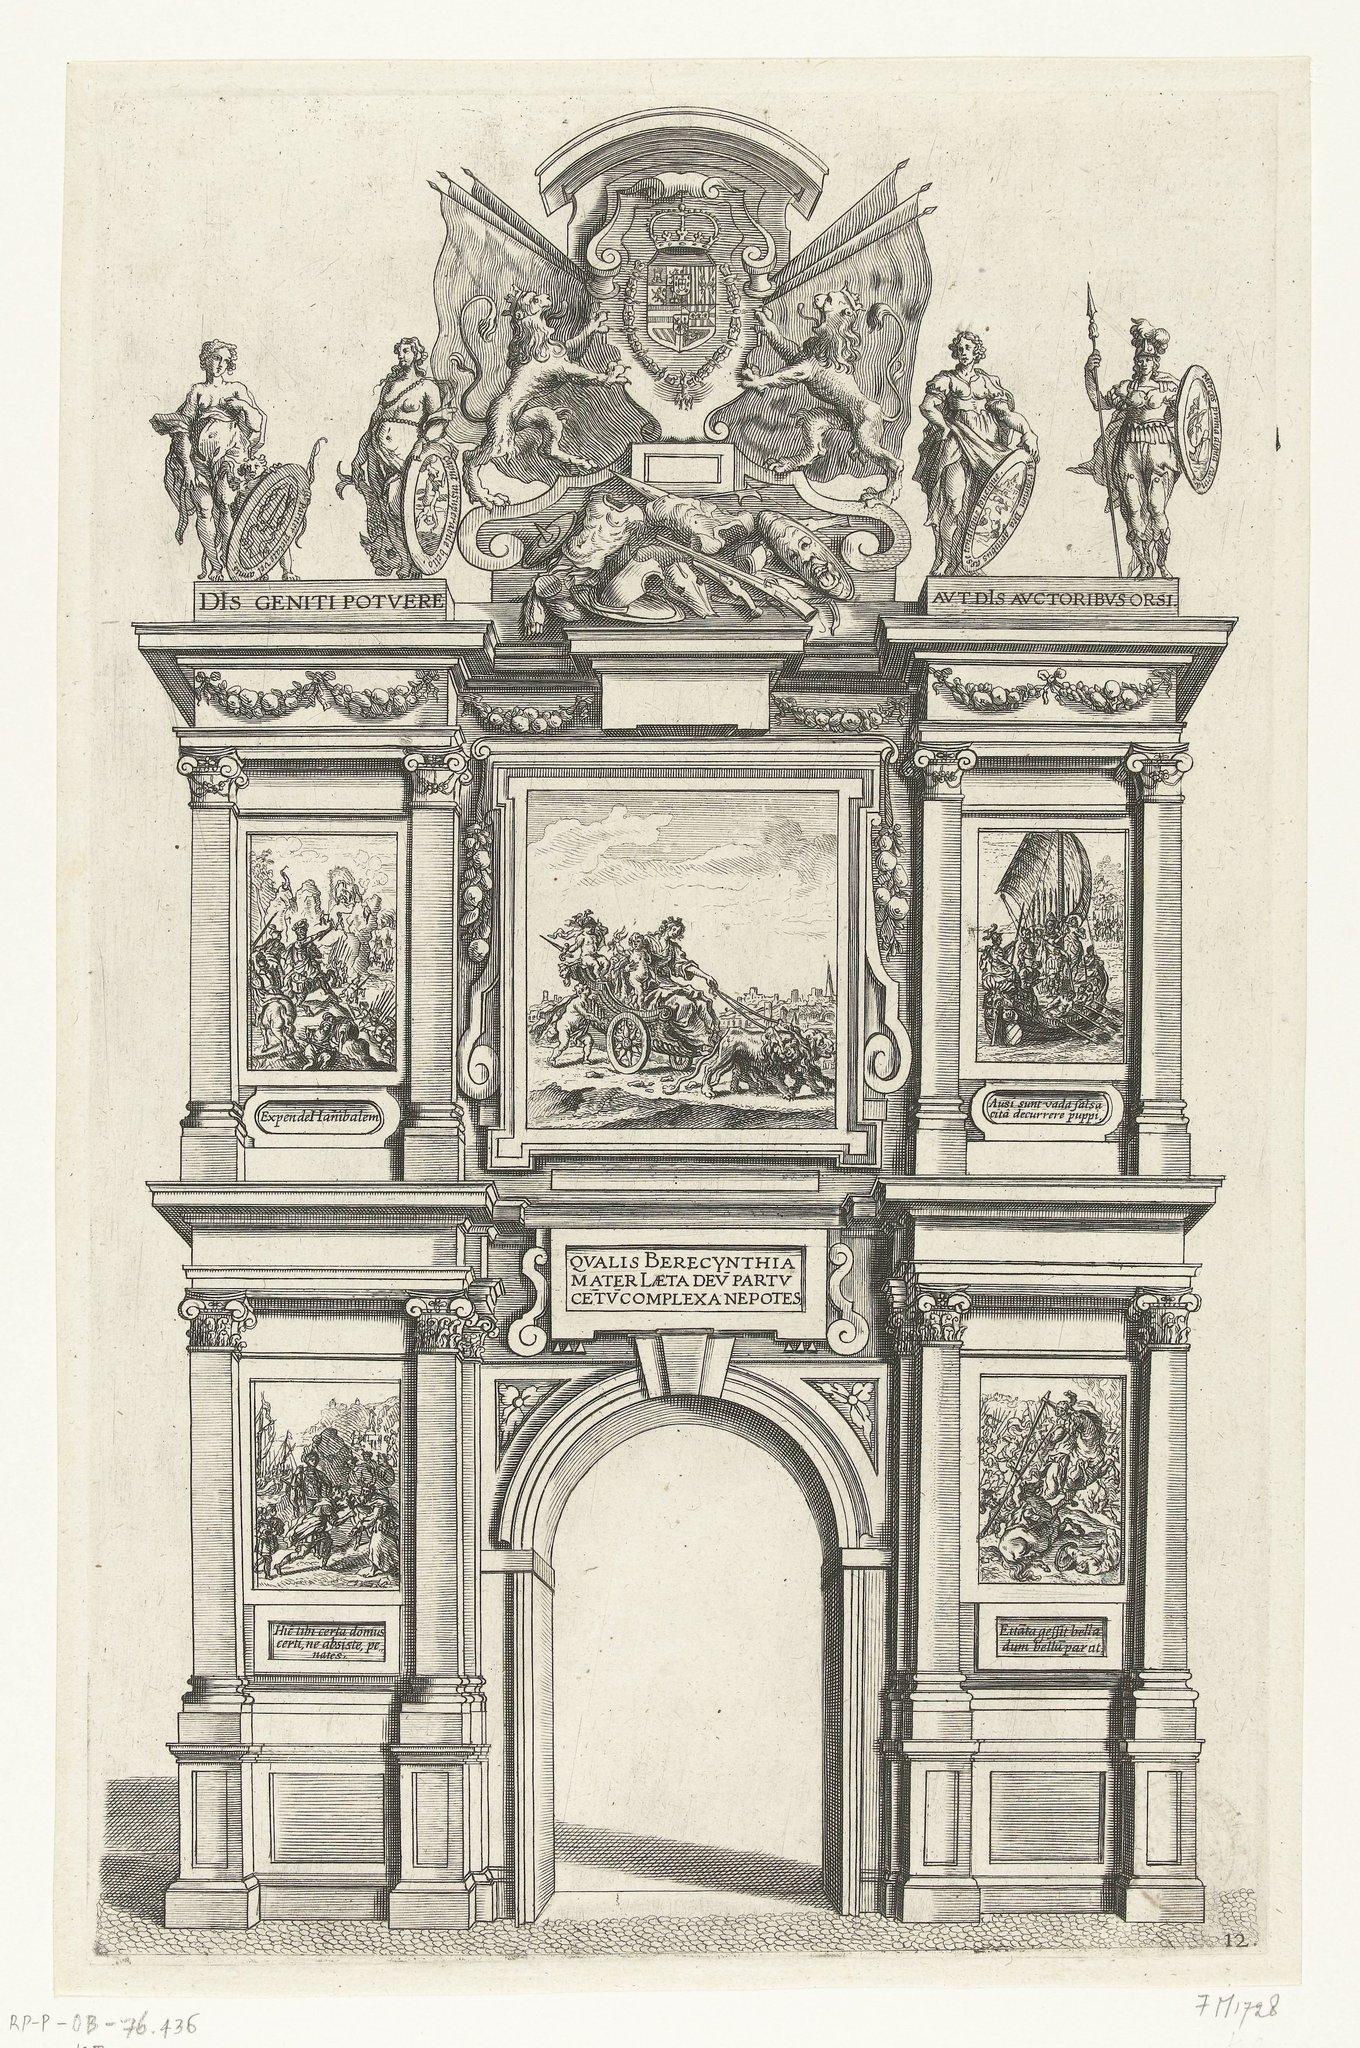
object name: print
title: Posterior portae triumphalis facies. Historiae similes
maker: Anonymous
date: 1635-1636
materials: paper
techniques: engraving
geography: southern netherlands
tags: brussels, landvoogd der zuidelijke nederlanden ferdinand van oostenrijk, triumphal arch, ghent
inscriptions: collector's mark: Lugt 240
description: Achterzijde van de triomfpoort Arcus Fernandi op de Vrijdagmarkt. Triomfpoort versierd met historische en allegorische scènes en figuren. Blad nr. 12 in een geheel van 42 platen die de uitgave van de beschrijving van de intocht van de Kardinaal Infant Ferdinand van Oostenrijk te Gent op 28 januari 1635 als de nieuwe landvoogd voor de Spaanse Nederlanden illustreren.